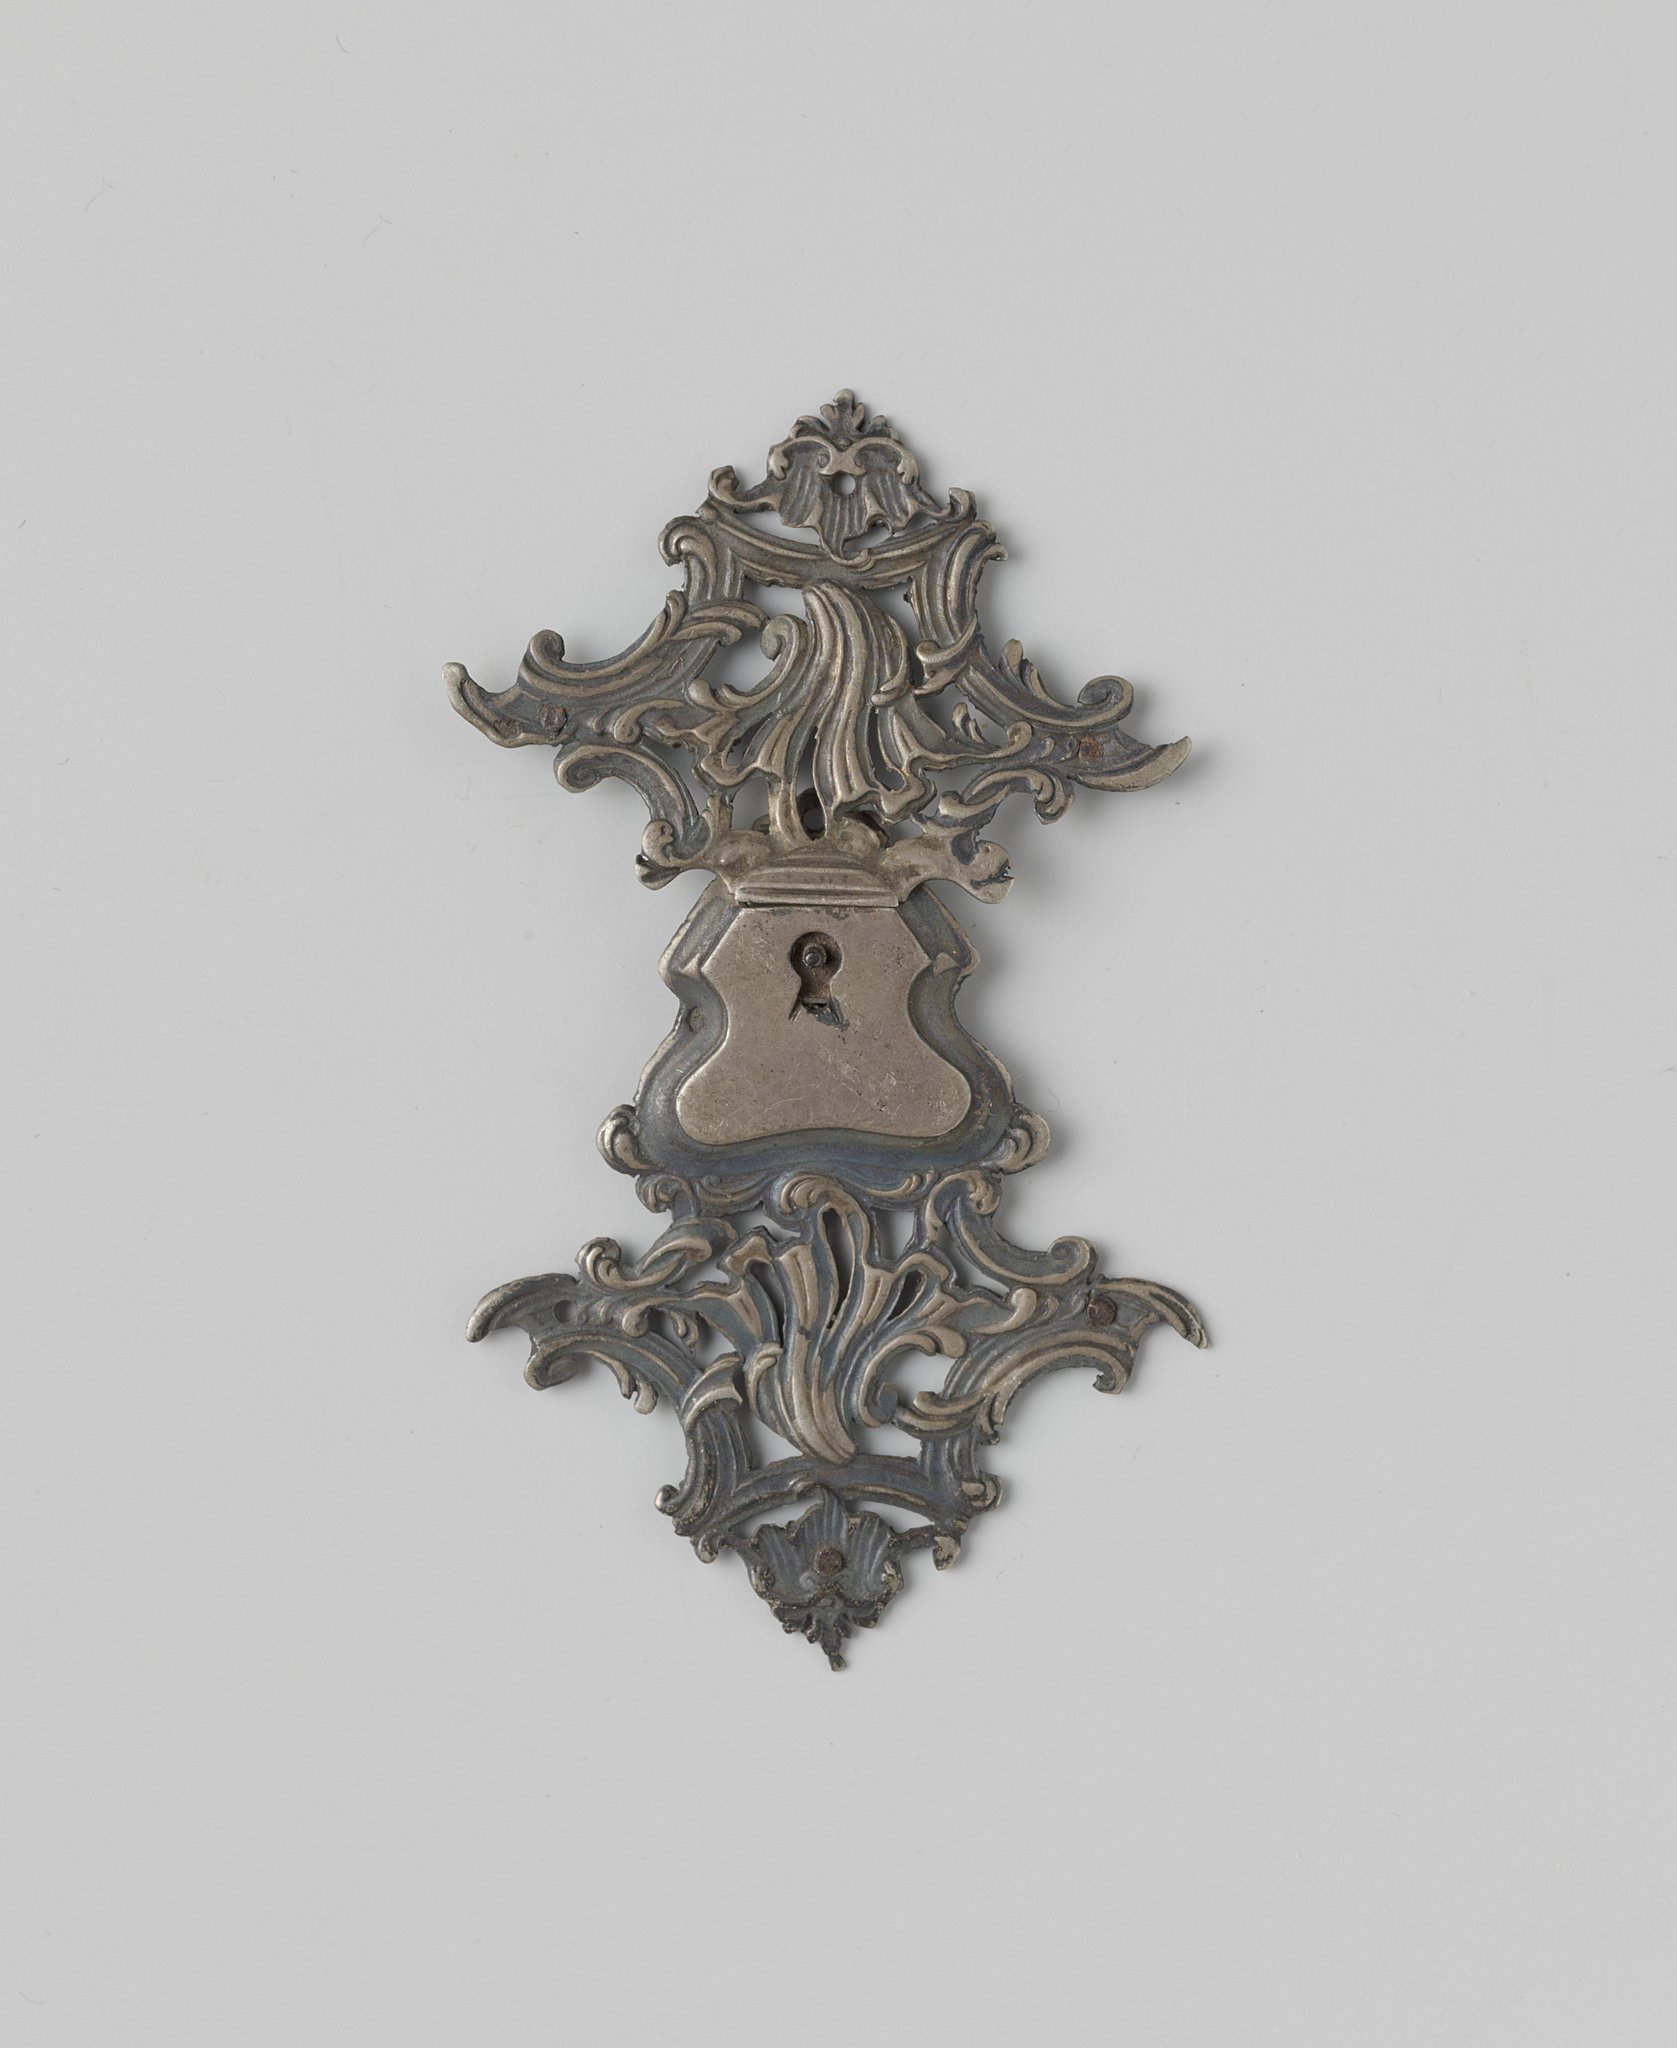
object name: beslag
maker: Anonymous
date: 1400-1950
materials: silver